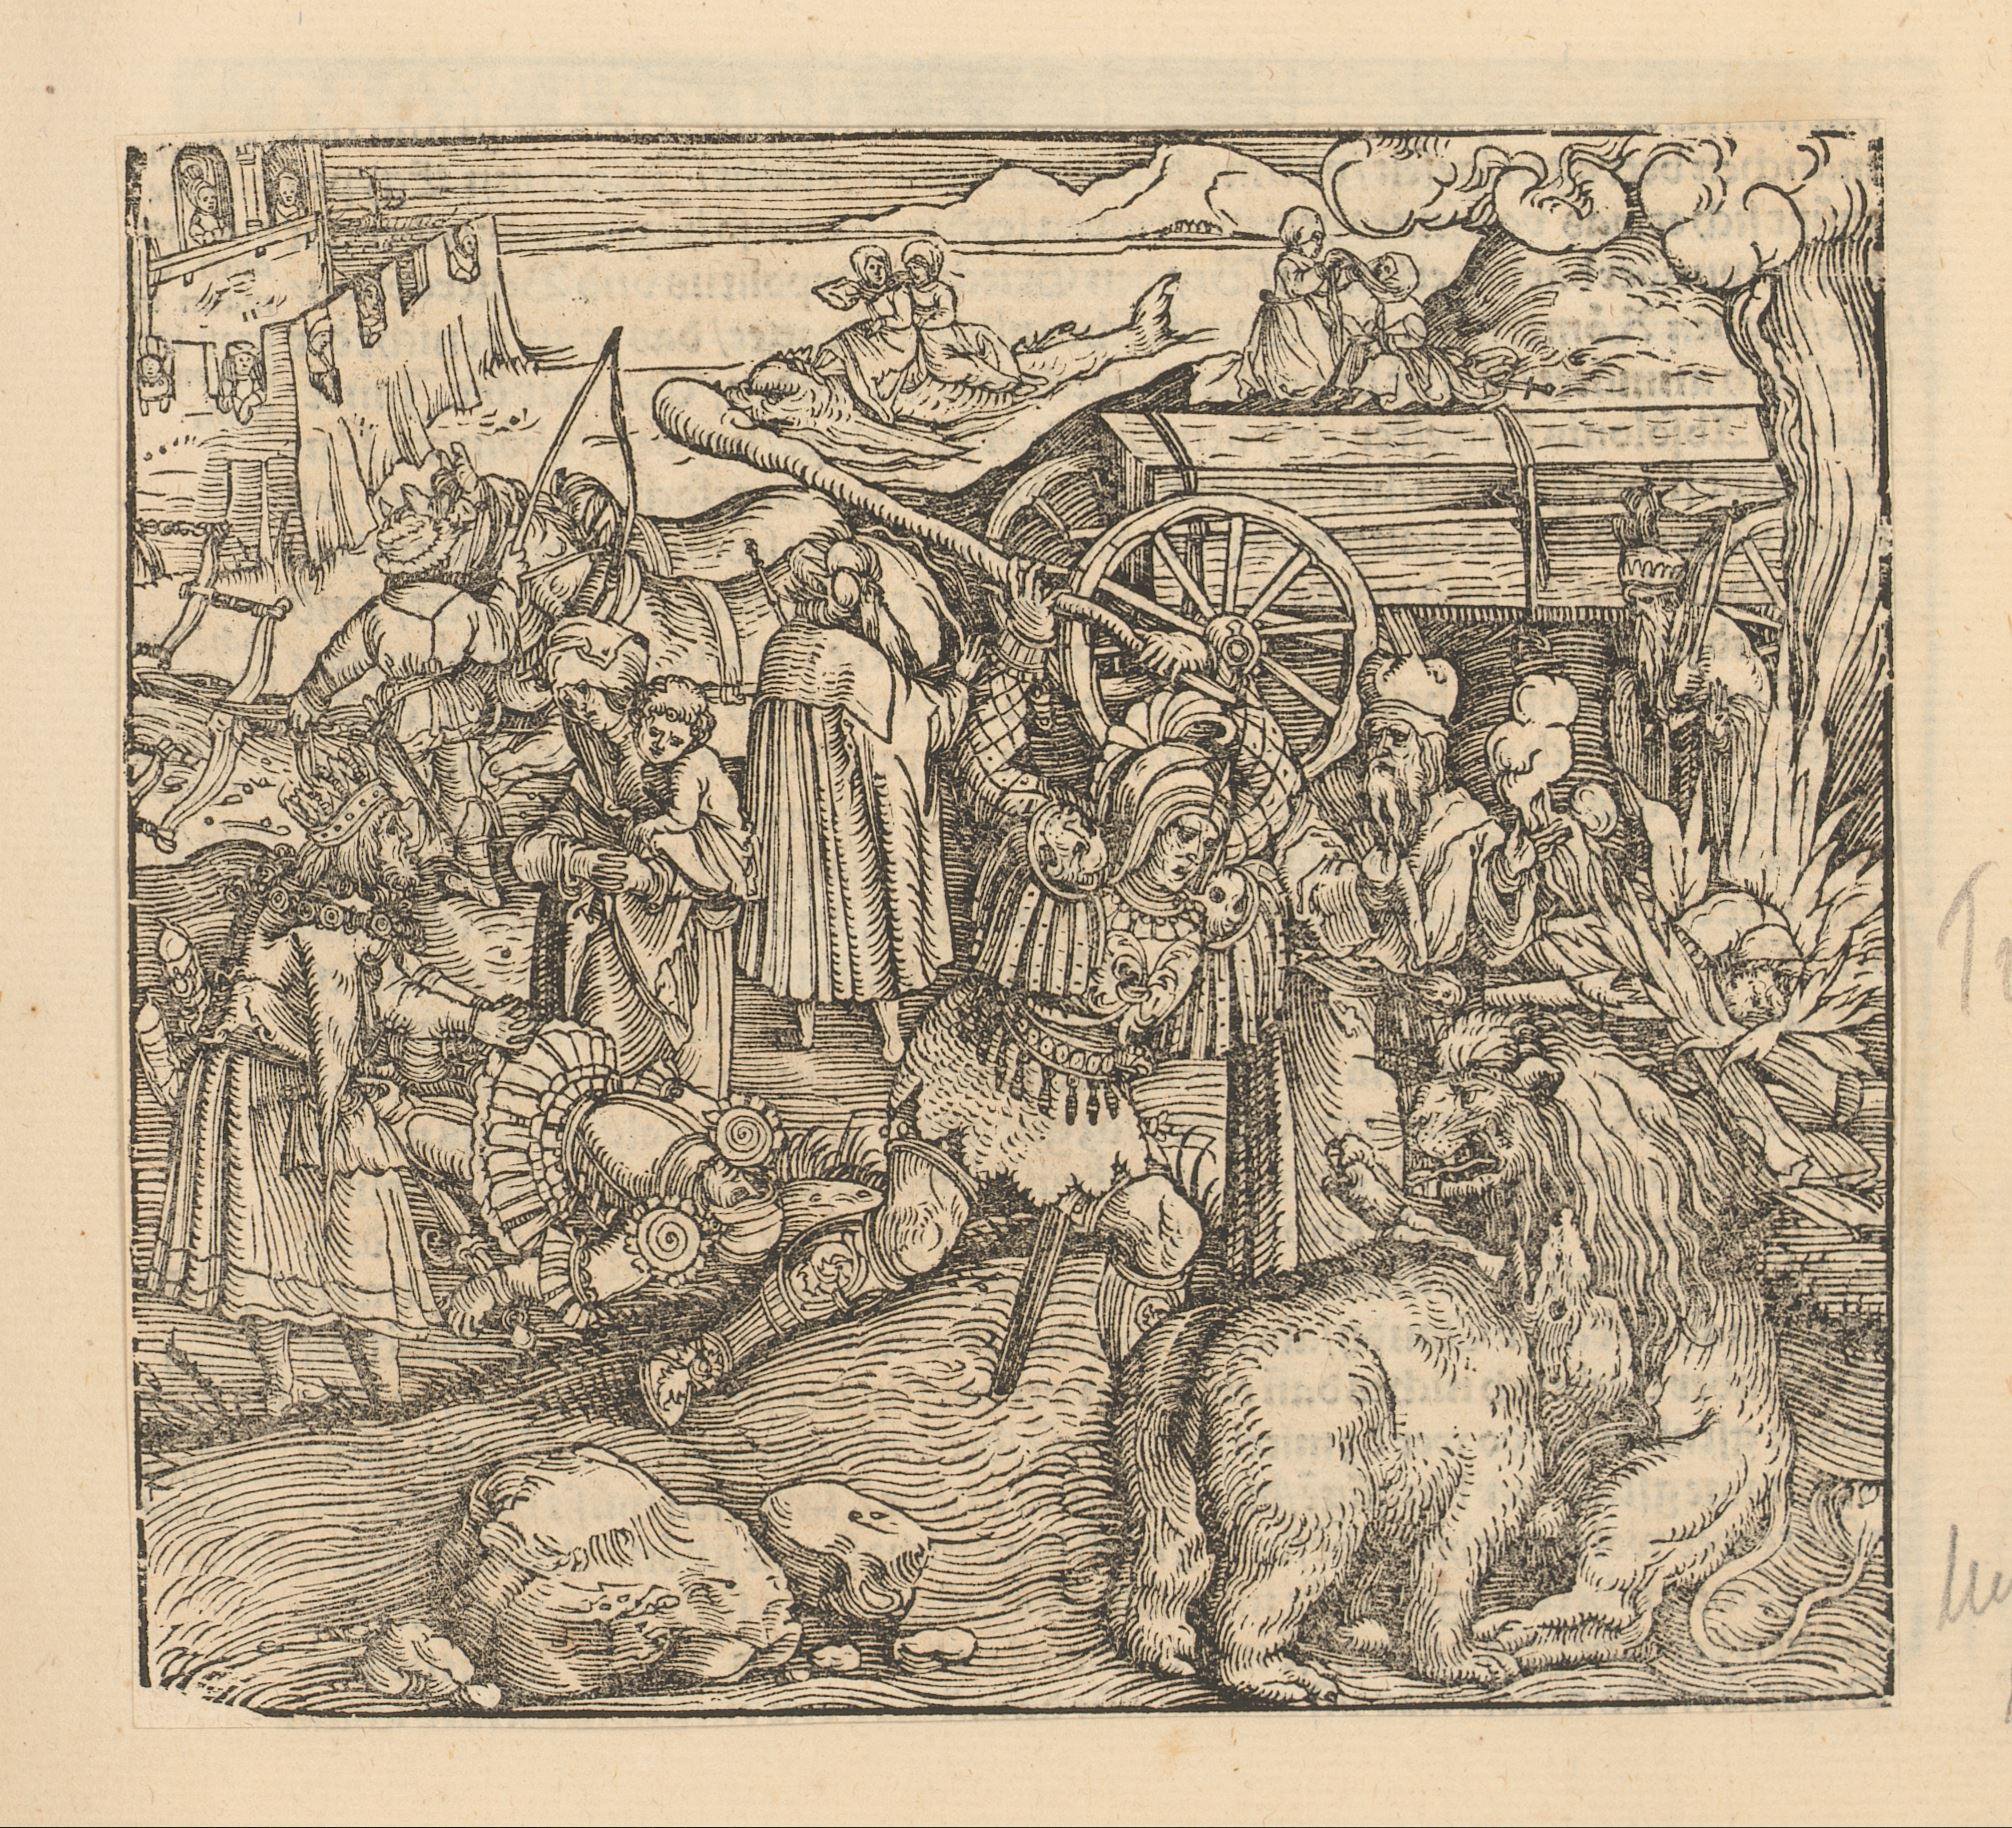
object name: book illustration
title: Soldaat knuppelt een vechtende leeuw en beer en op de achtergrond een vestingstad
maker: Anonymous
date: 1514-1532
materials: paper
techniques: letterpress printing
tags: dangerous wild animals ~ restraint of animals, hector - suffering, misfortune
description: Deze prent is gebruikt in: Petrarca, Francesco. Von der Artzney bayder Glück, des guten und widerwertigen: unnd weß sich ain yeder inn Gelück und Unglück halten sol (...). Augsburg: Heinrich Steiner, 1532. Deze uitgave is ook bekend onder de titel 'Trostspiegel in Glück und Unglück'.